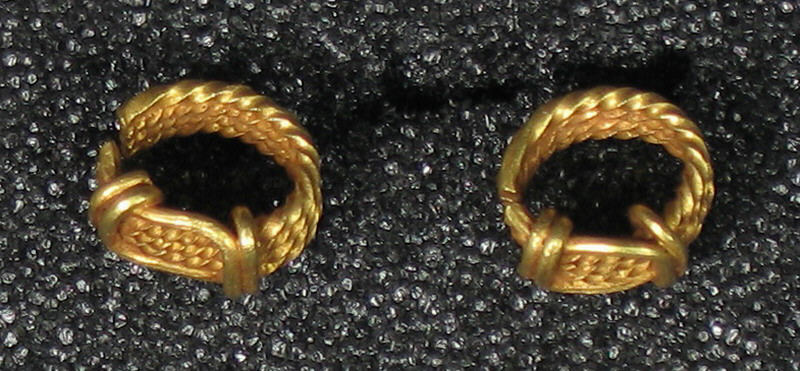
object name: pair of earring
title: Pair of Earrings, Pennanular Hoop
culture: indonesian, central java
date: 701-1200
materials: gold